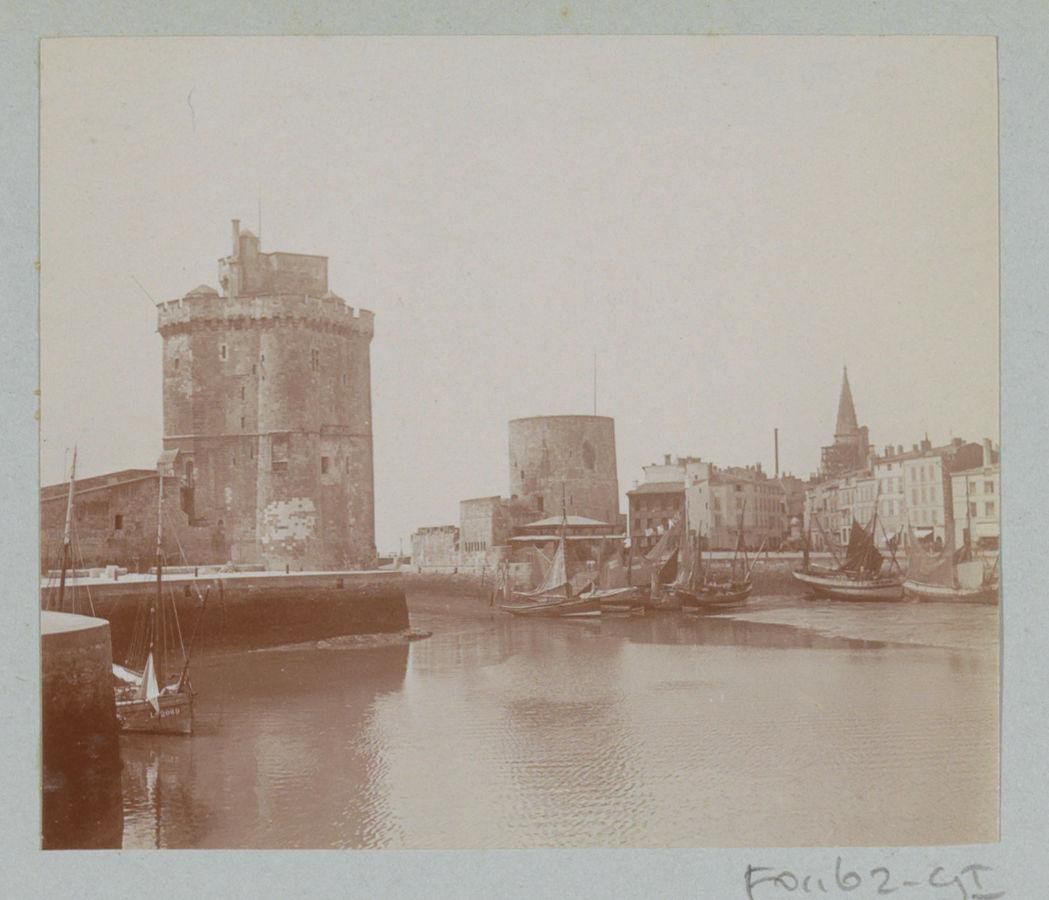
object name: photograph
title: Haveningang van La Rochelle met links de Tour Saint-Nicolas en in het midden de Tour de la Chaîne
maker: Anonymous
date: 1905-1910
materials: paper, photographic support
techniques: gelatin silver print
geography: la rochelle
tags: towers ~ fortified city, harbour (+ view ~ vehicle, ship, etc.)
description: Onderdeel van Fotoalbum van een Franse amateurfotograaf met bezienswaardigheden in Frankrijk, Zwitserland en Italië.